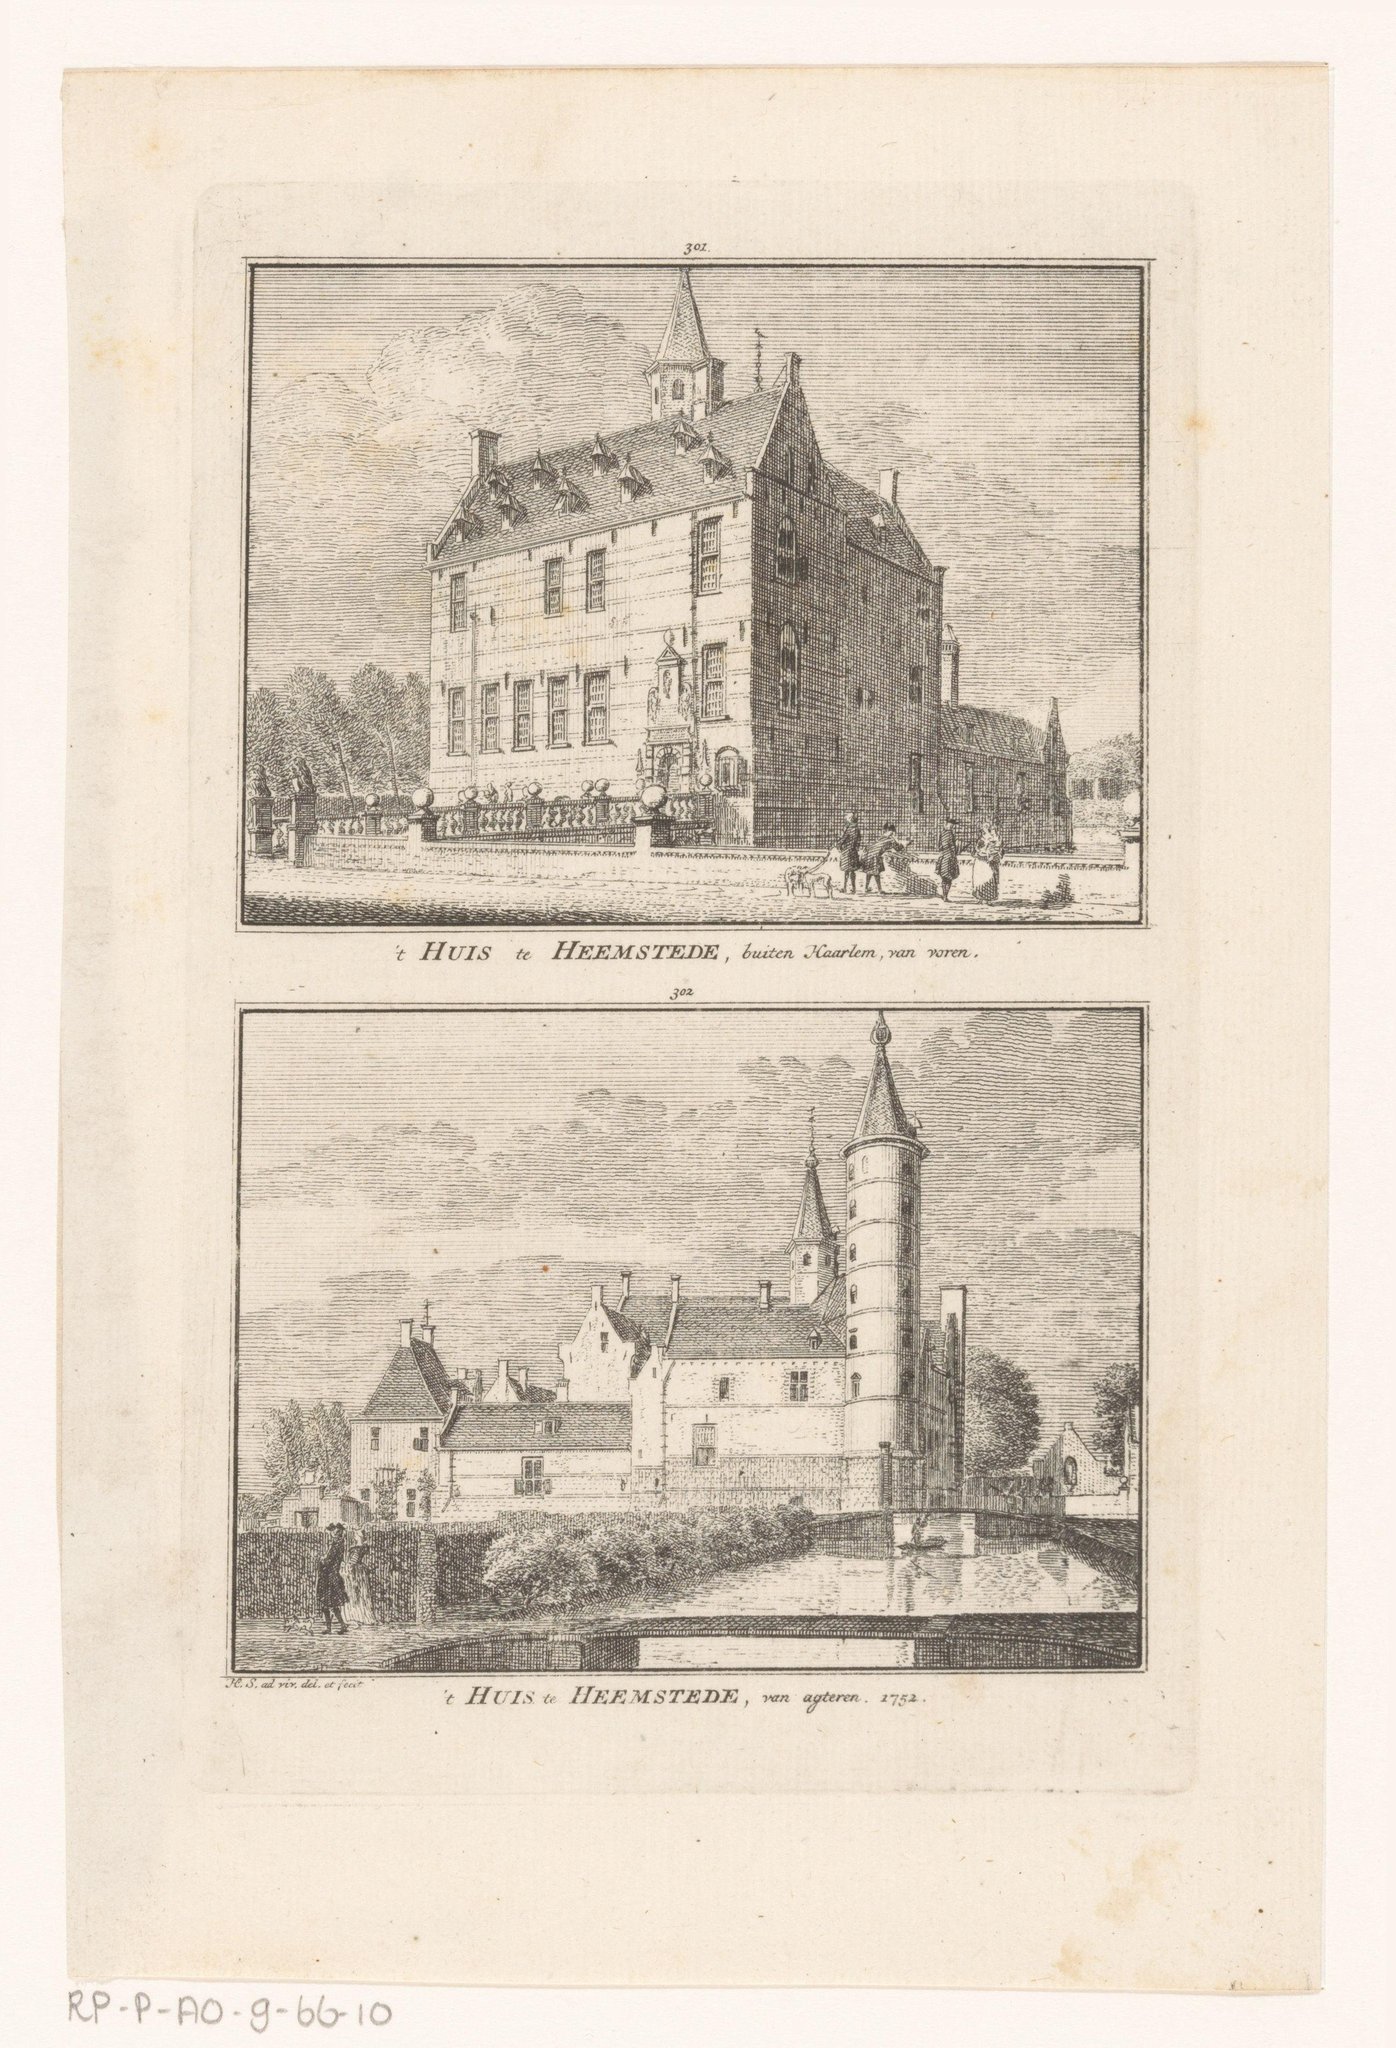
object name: book illustration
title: 't Huis te Heemstede, buiten Haarlem, van voren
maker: hendrik spilman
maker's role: draughtsman, painter, print maker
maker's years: 1721-1784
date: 1752-1792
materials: paper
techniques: engraving, etching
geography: haarlem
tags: castle, bridge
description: Prent ook gebruikt in: Het verheerlykt Nederland of kabinet van hedendaagsche gezigten van steden, dorpen (…). 9 delen. Amsterdam: Isaak Tirion en weduwe Isaak Tirion, 1745-1774, dl. 4 (1752), ill. 301 en 302. Of in: Nederlandsche tafereelen; of eene keurige verzameling van negen honderd fraaije gezigten van steden, dorpen, sloten, oudheden (….). 9 delen. Amsterdam: Jan de Groot, 1792, dl. 4, ill. 301 en 302. Uit welke druk het huidige exemplaar precies komt is niet na te gaan.